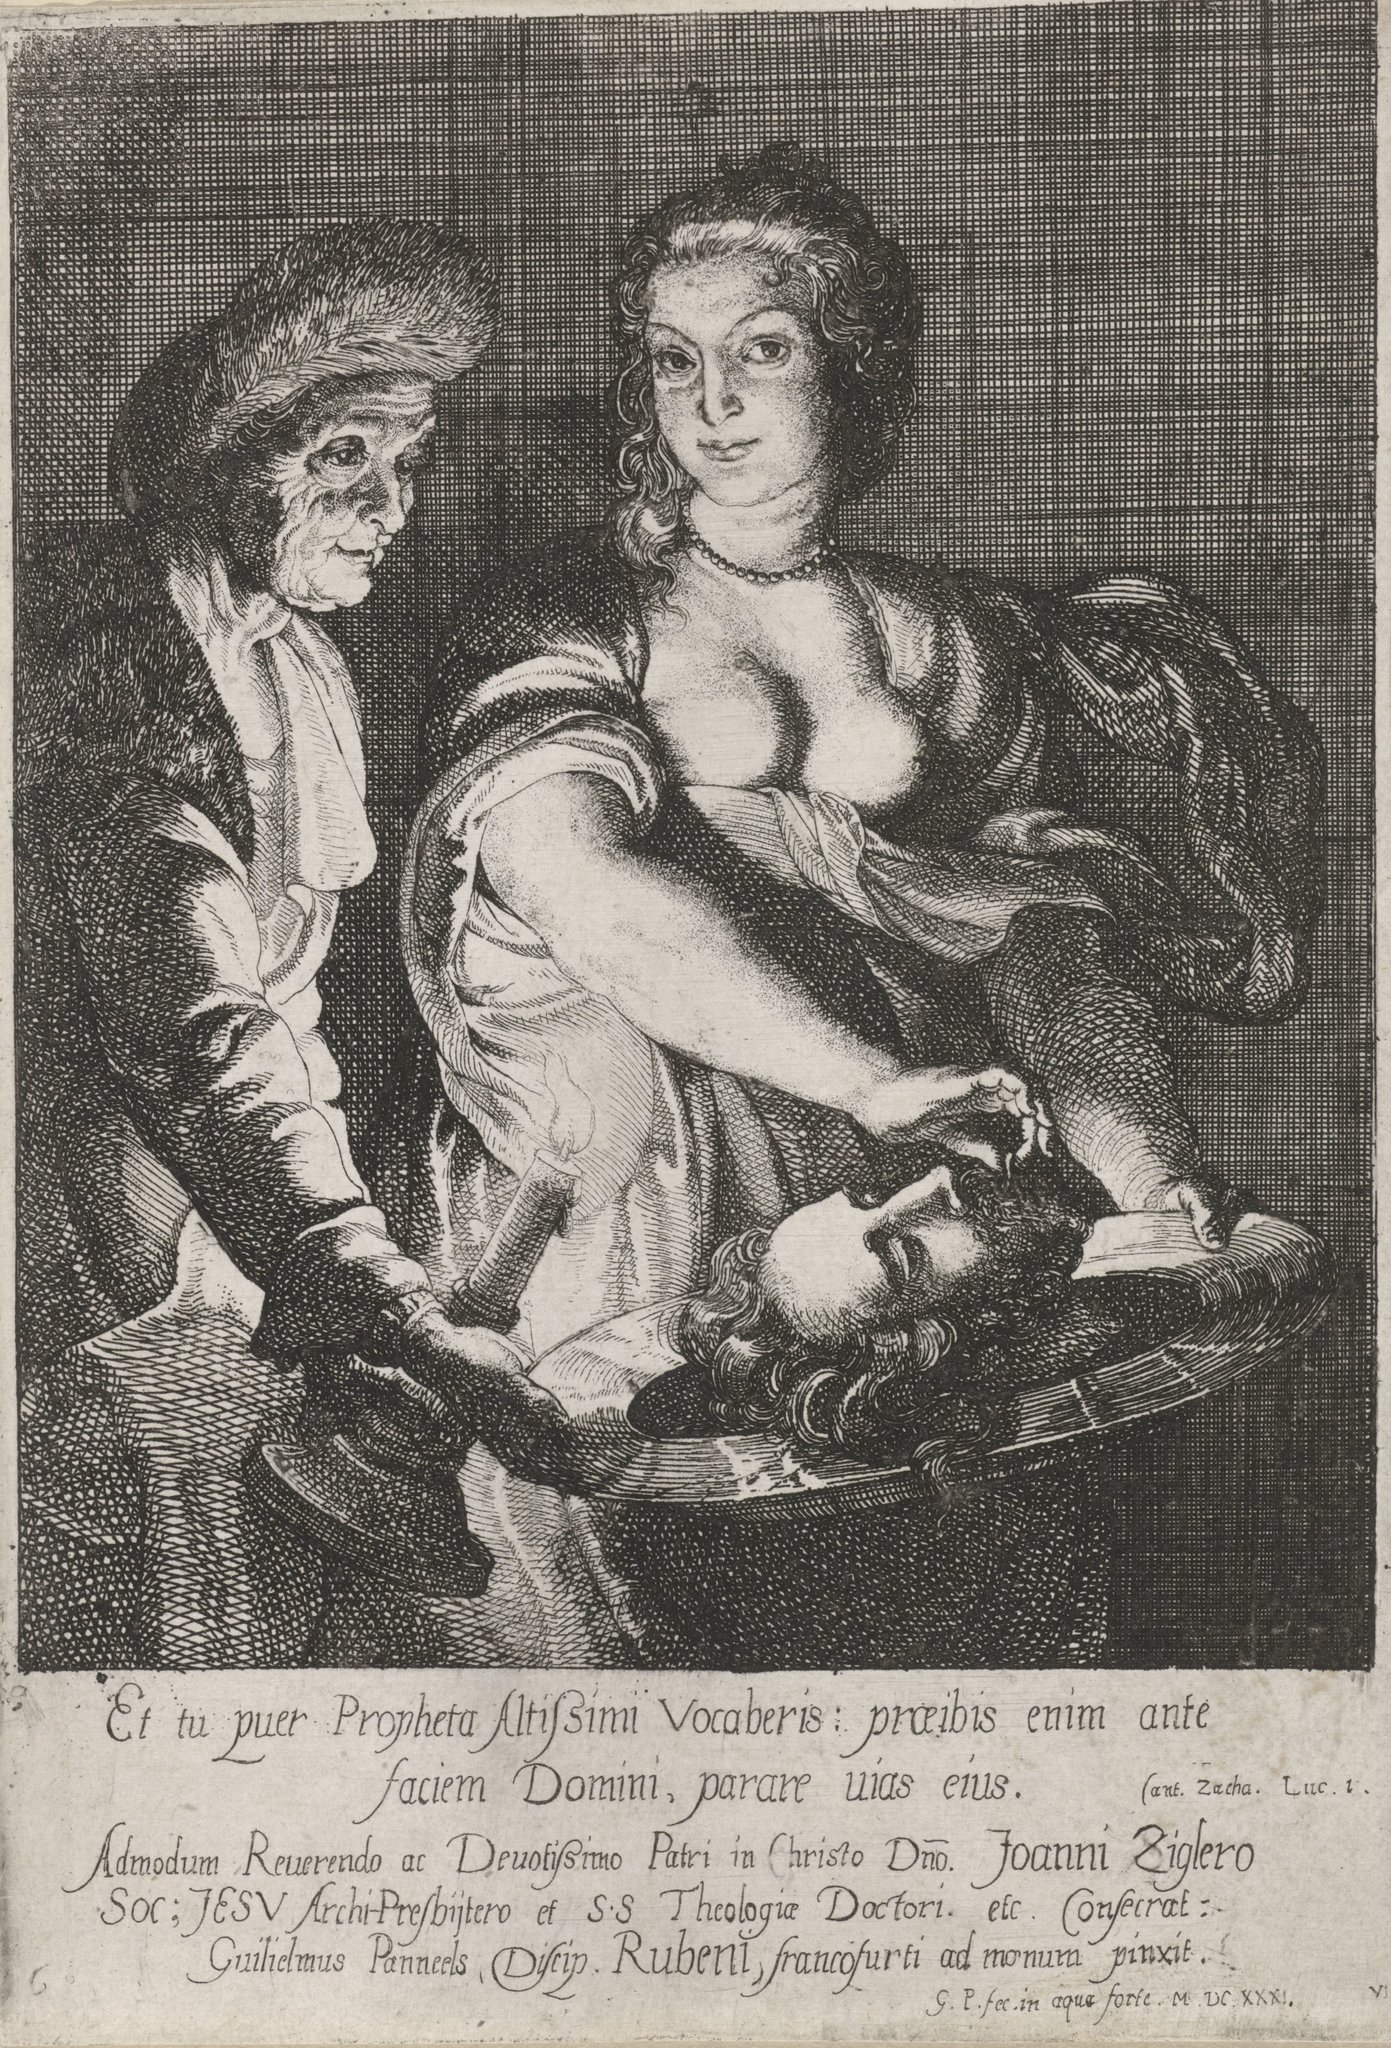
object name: print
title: Salome met het hoofd van Johannes de Doper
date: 1631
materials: paper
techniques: engraving, etching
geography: frankfurt am main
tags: salome gives the head of john the baptist to her mother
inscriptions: collector's mark: Lugt 240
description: Salome geeft de schotel met het hoofd van Johannes de Doper aan haar moeder Herodias. In de marge een onderschrift in het Latijn.